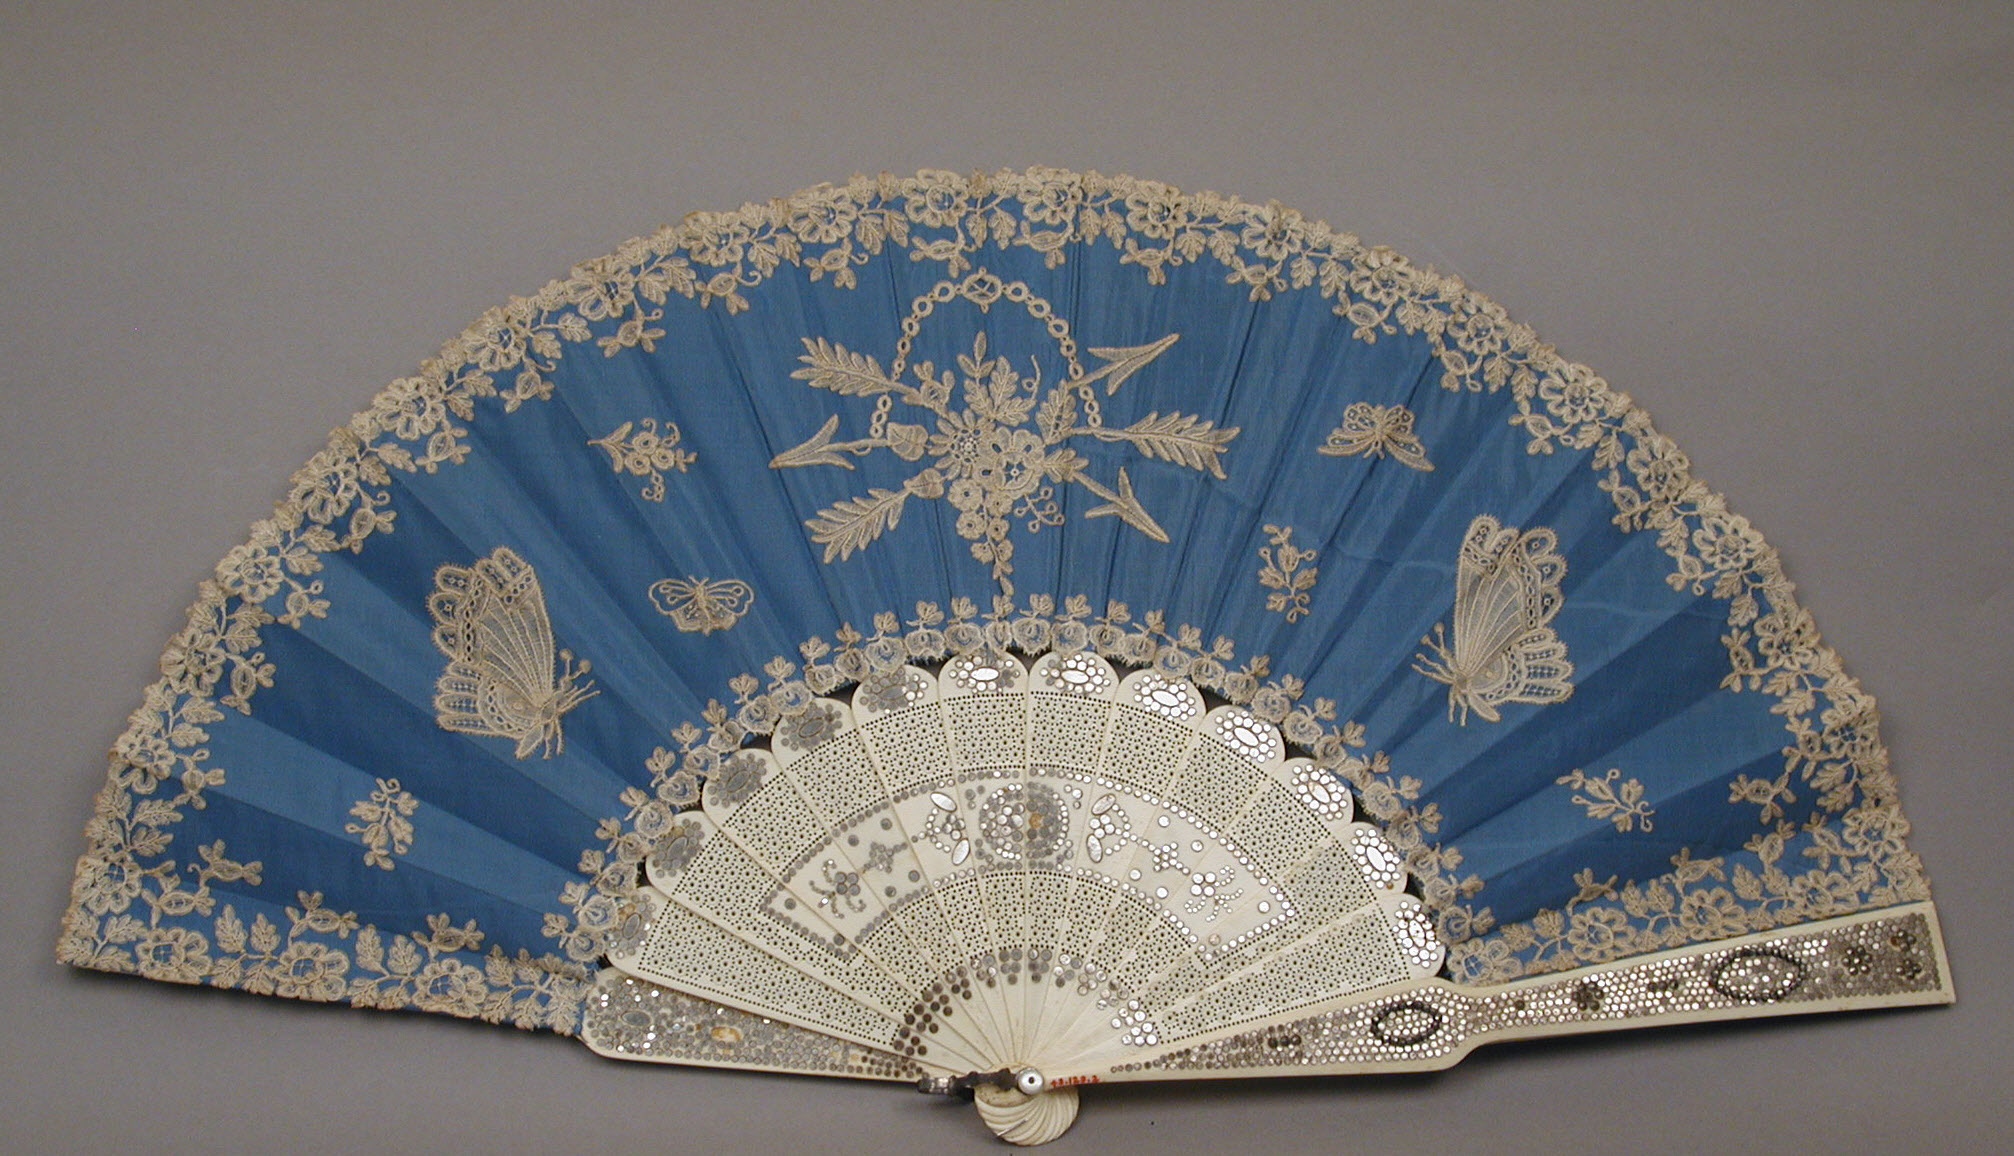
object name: fan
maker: a. rodien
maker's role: manufacturer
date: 1870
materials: ivory, mother of pearl, silk, steel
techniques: lace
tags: butterflies